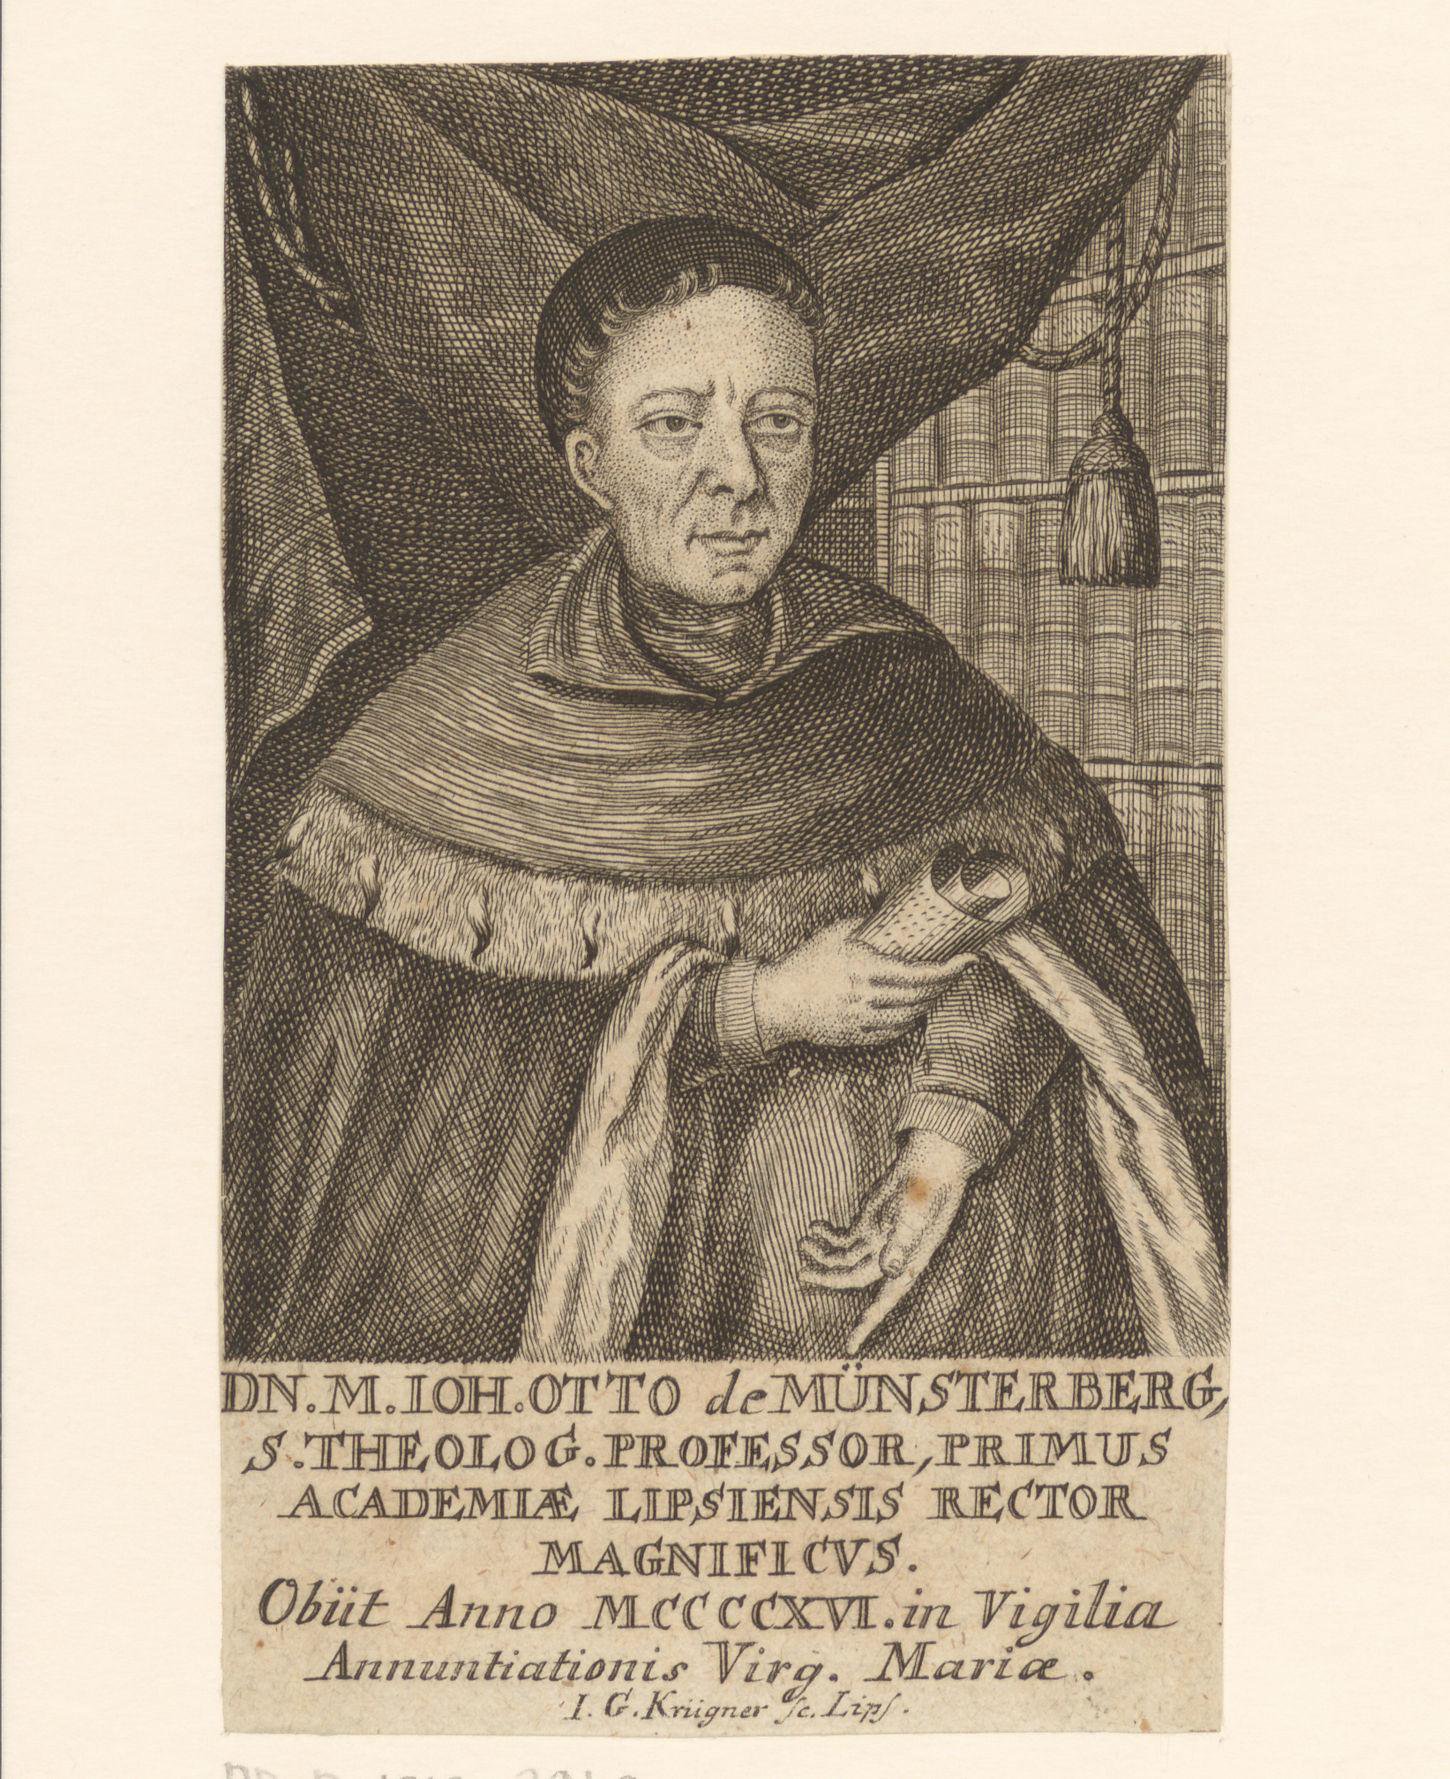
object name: print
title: Portret van Johannes Otto van Münsterberg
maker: johann gottfried krügner (i)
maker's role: artist, print maker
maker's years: 1684-1769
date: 1694-1769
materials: paper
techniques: engraving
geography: leipzig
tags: theologian, historical persons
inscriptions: collector's mark: Lugt 2228